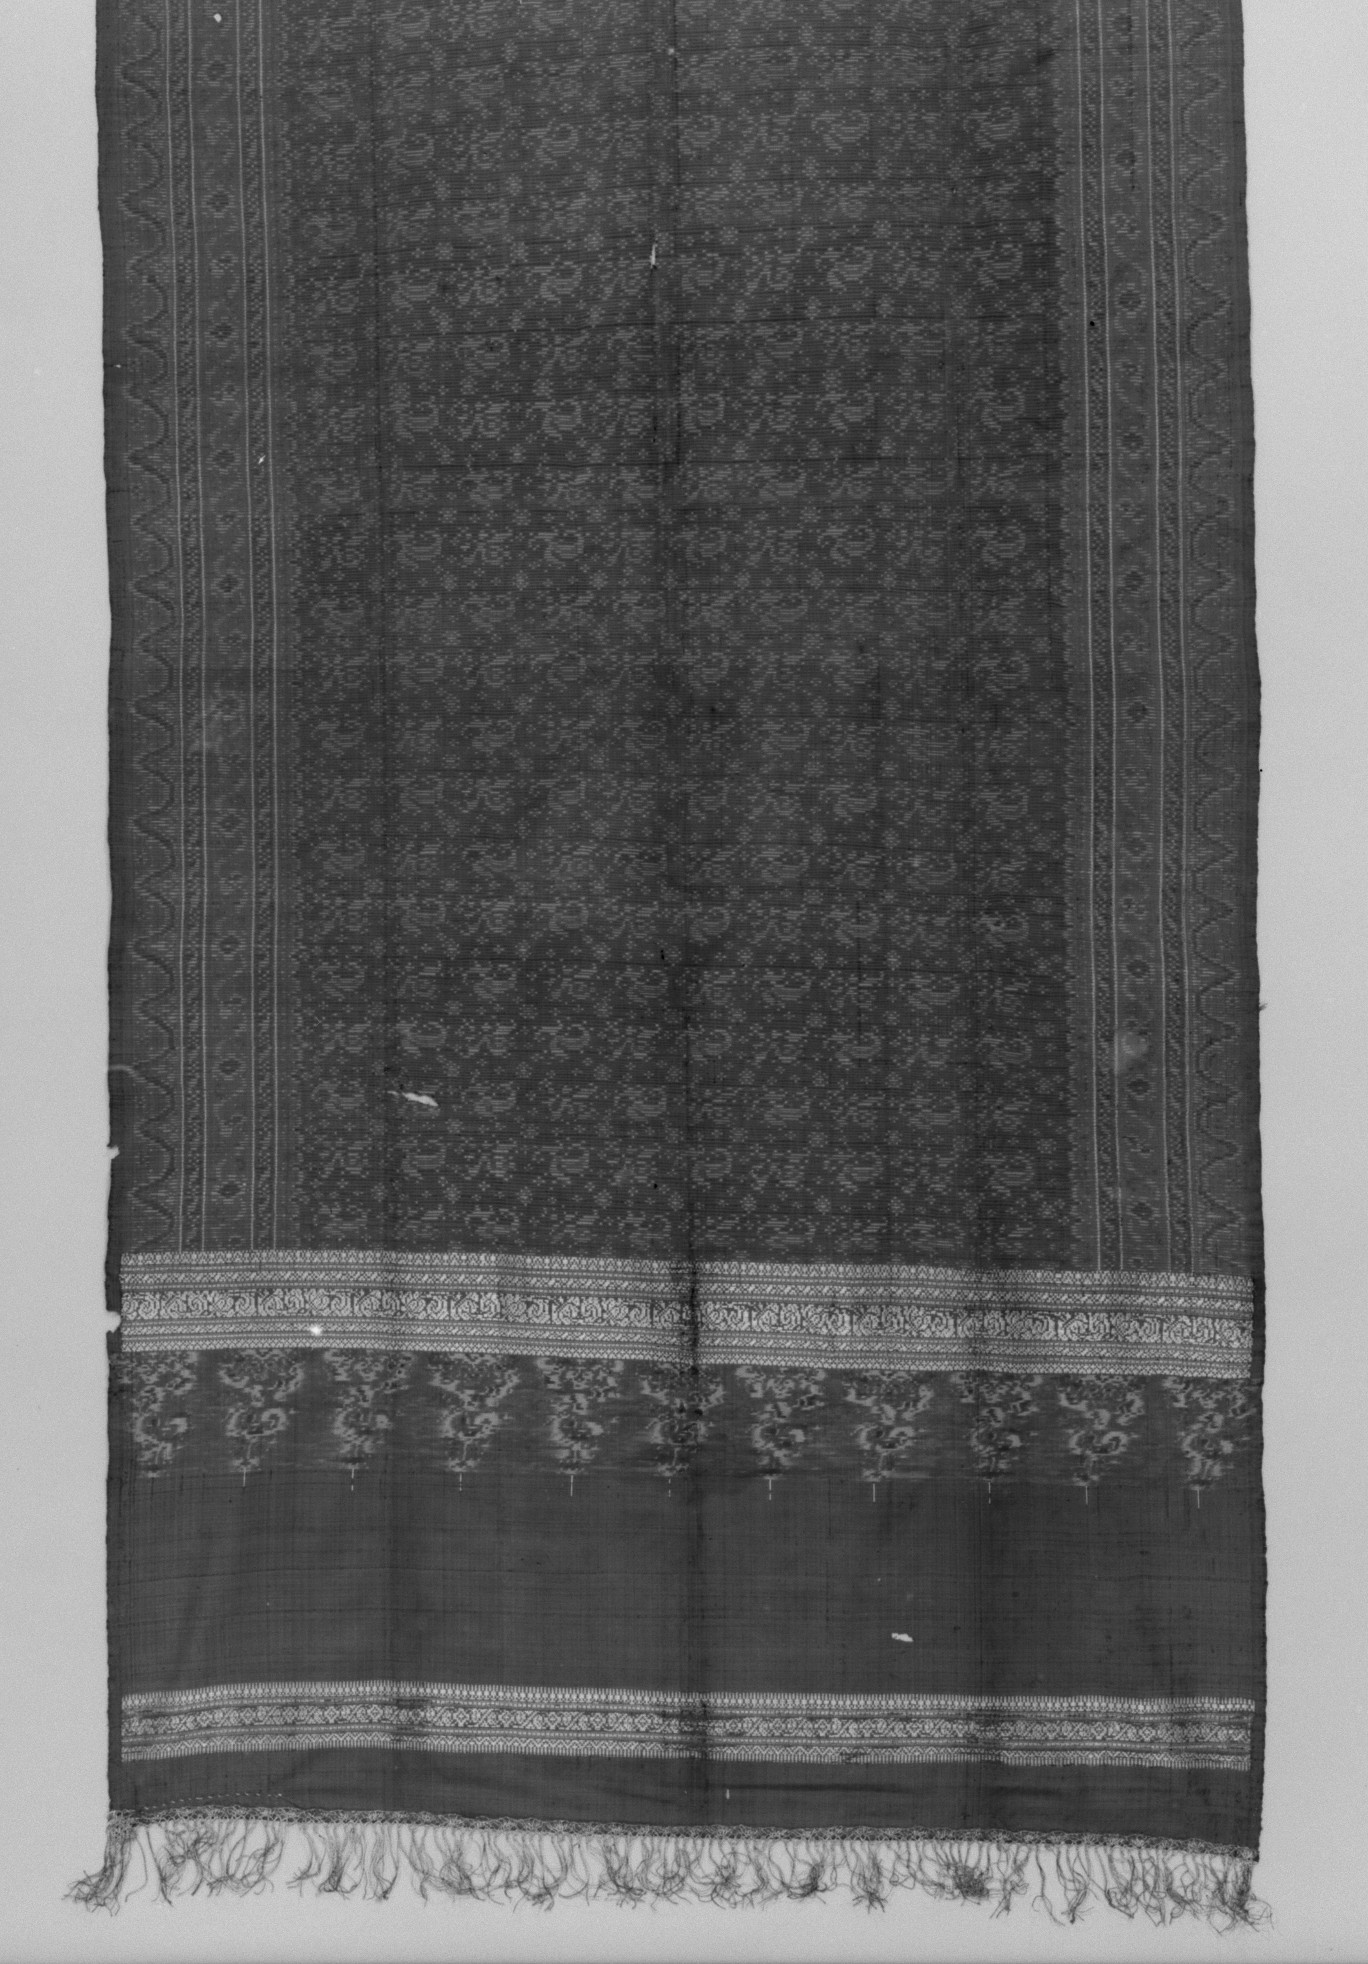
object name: sarong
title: Man's Sarong (Kain Lepas)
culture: sumatran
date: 1801-1900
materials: cotton, gold, thread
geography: indonesia